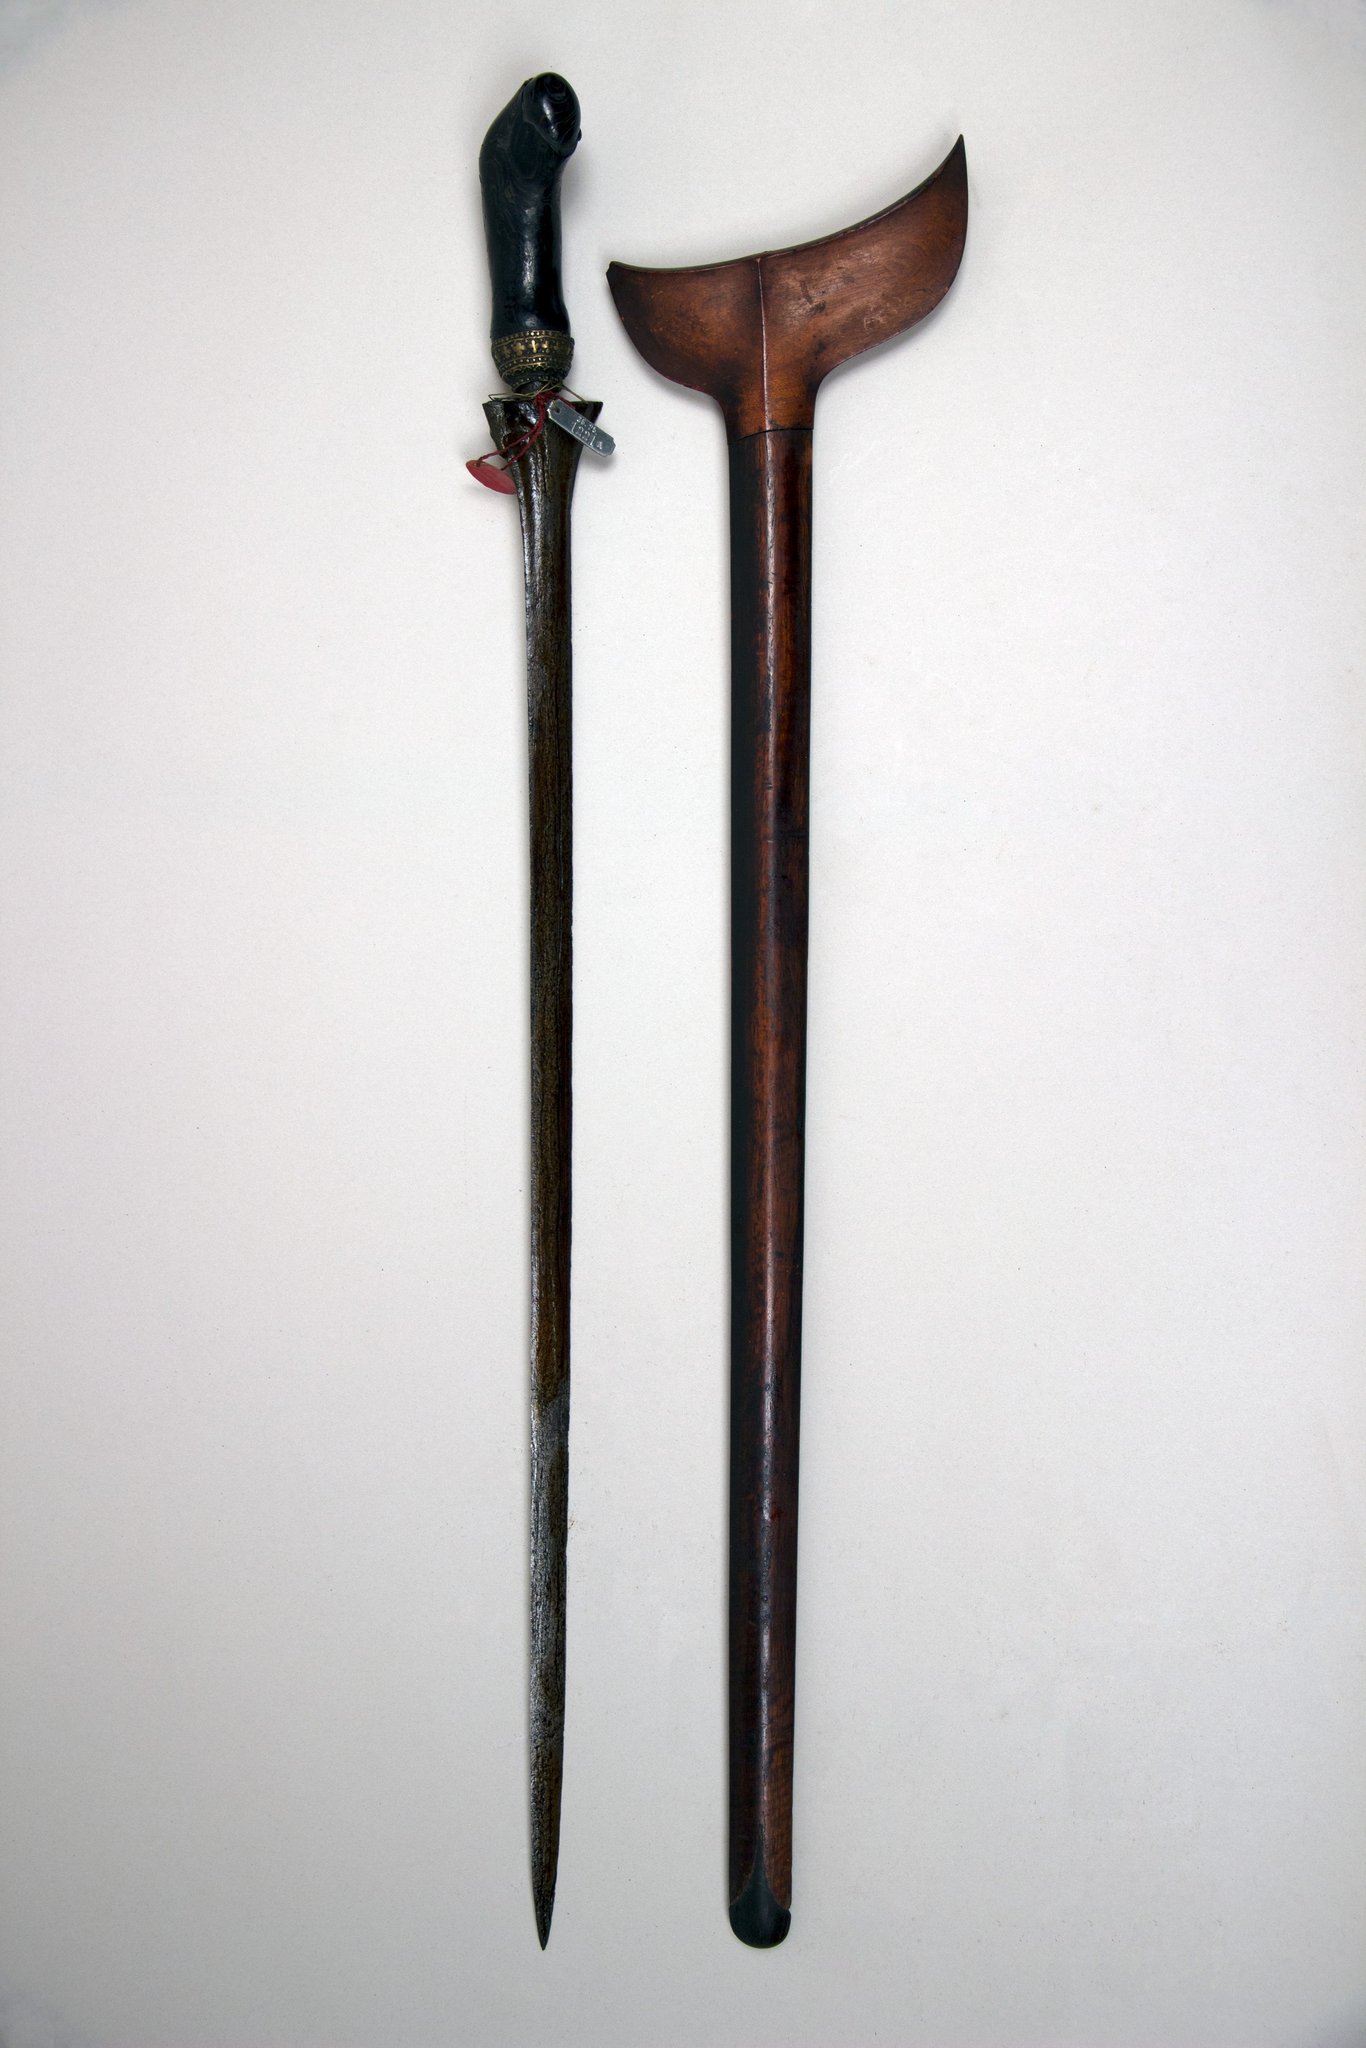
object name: executioner's kris with sheath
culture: malaysian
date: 1701-1900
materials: horn, wood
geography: malaysia